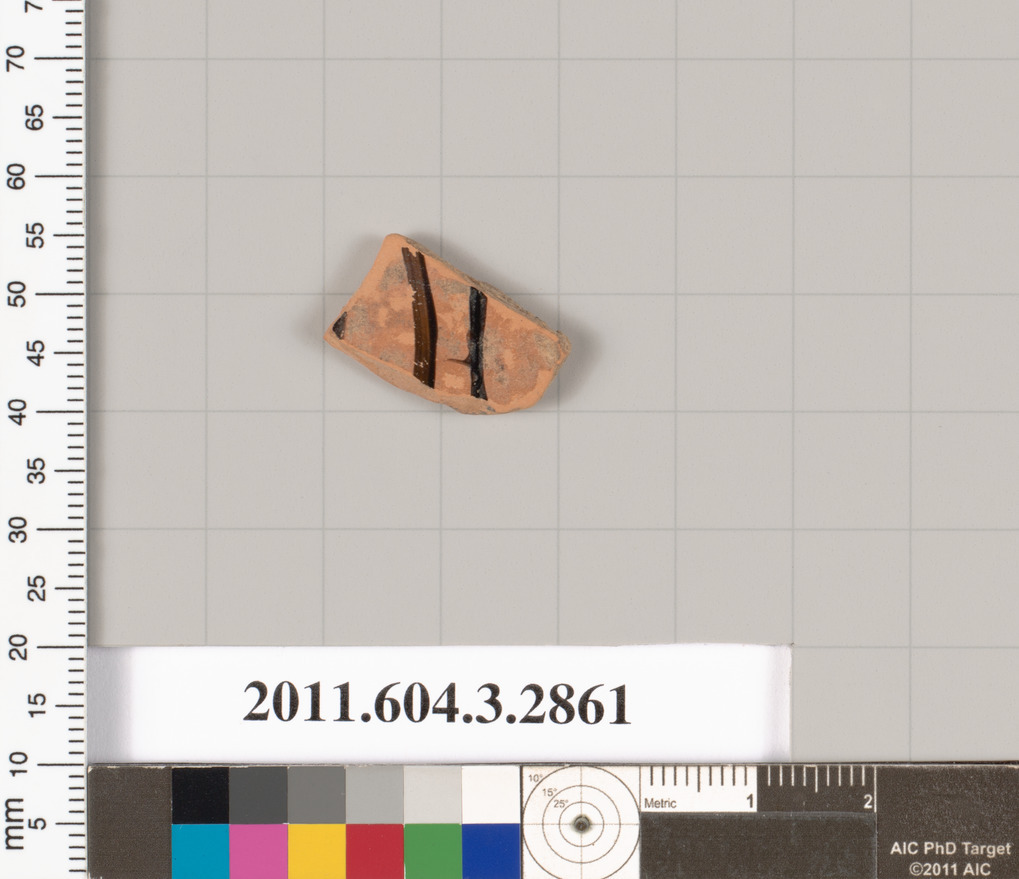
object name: undetermined closed shape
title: Terracotta fragment of a closed shape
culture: greek, attic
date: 534-468 BCE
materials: terracotta